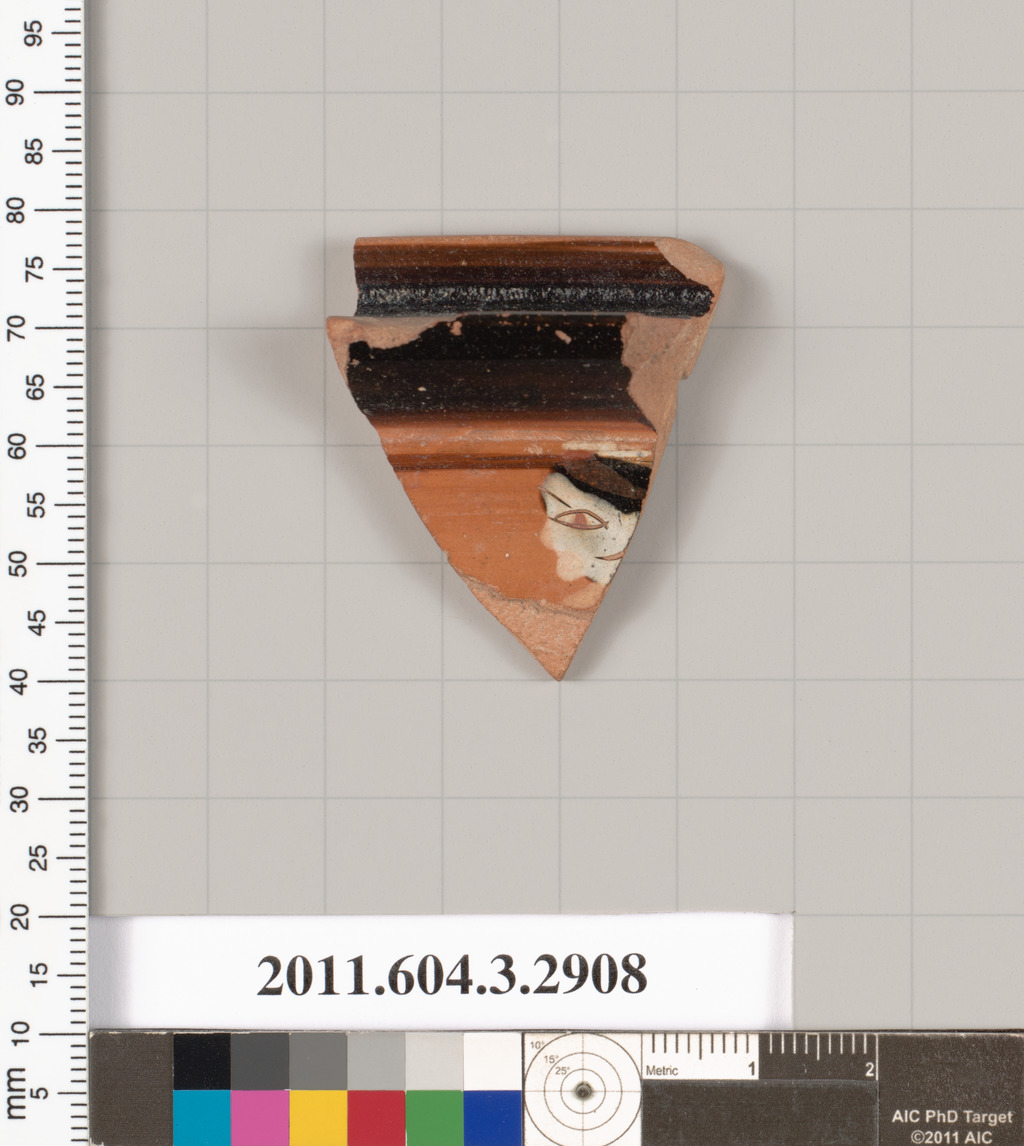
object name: pyxis fragment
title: Terracotta fragment of a pyxis (box)?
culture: greek, attic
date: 534-501 BCE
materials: terracotta